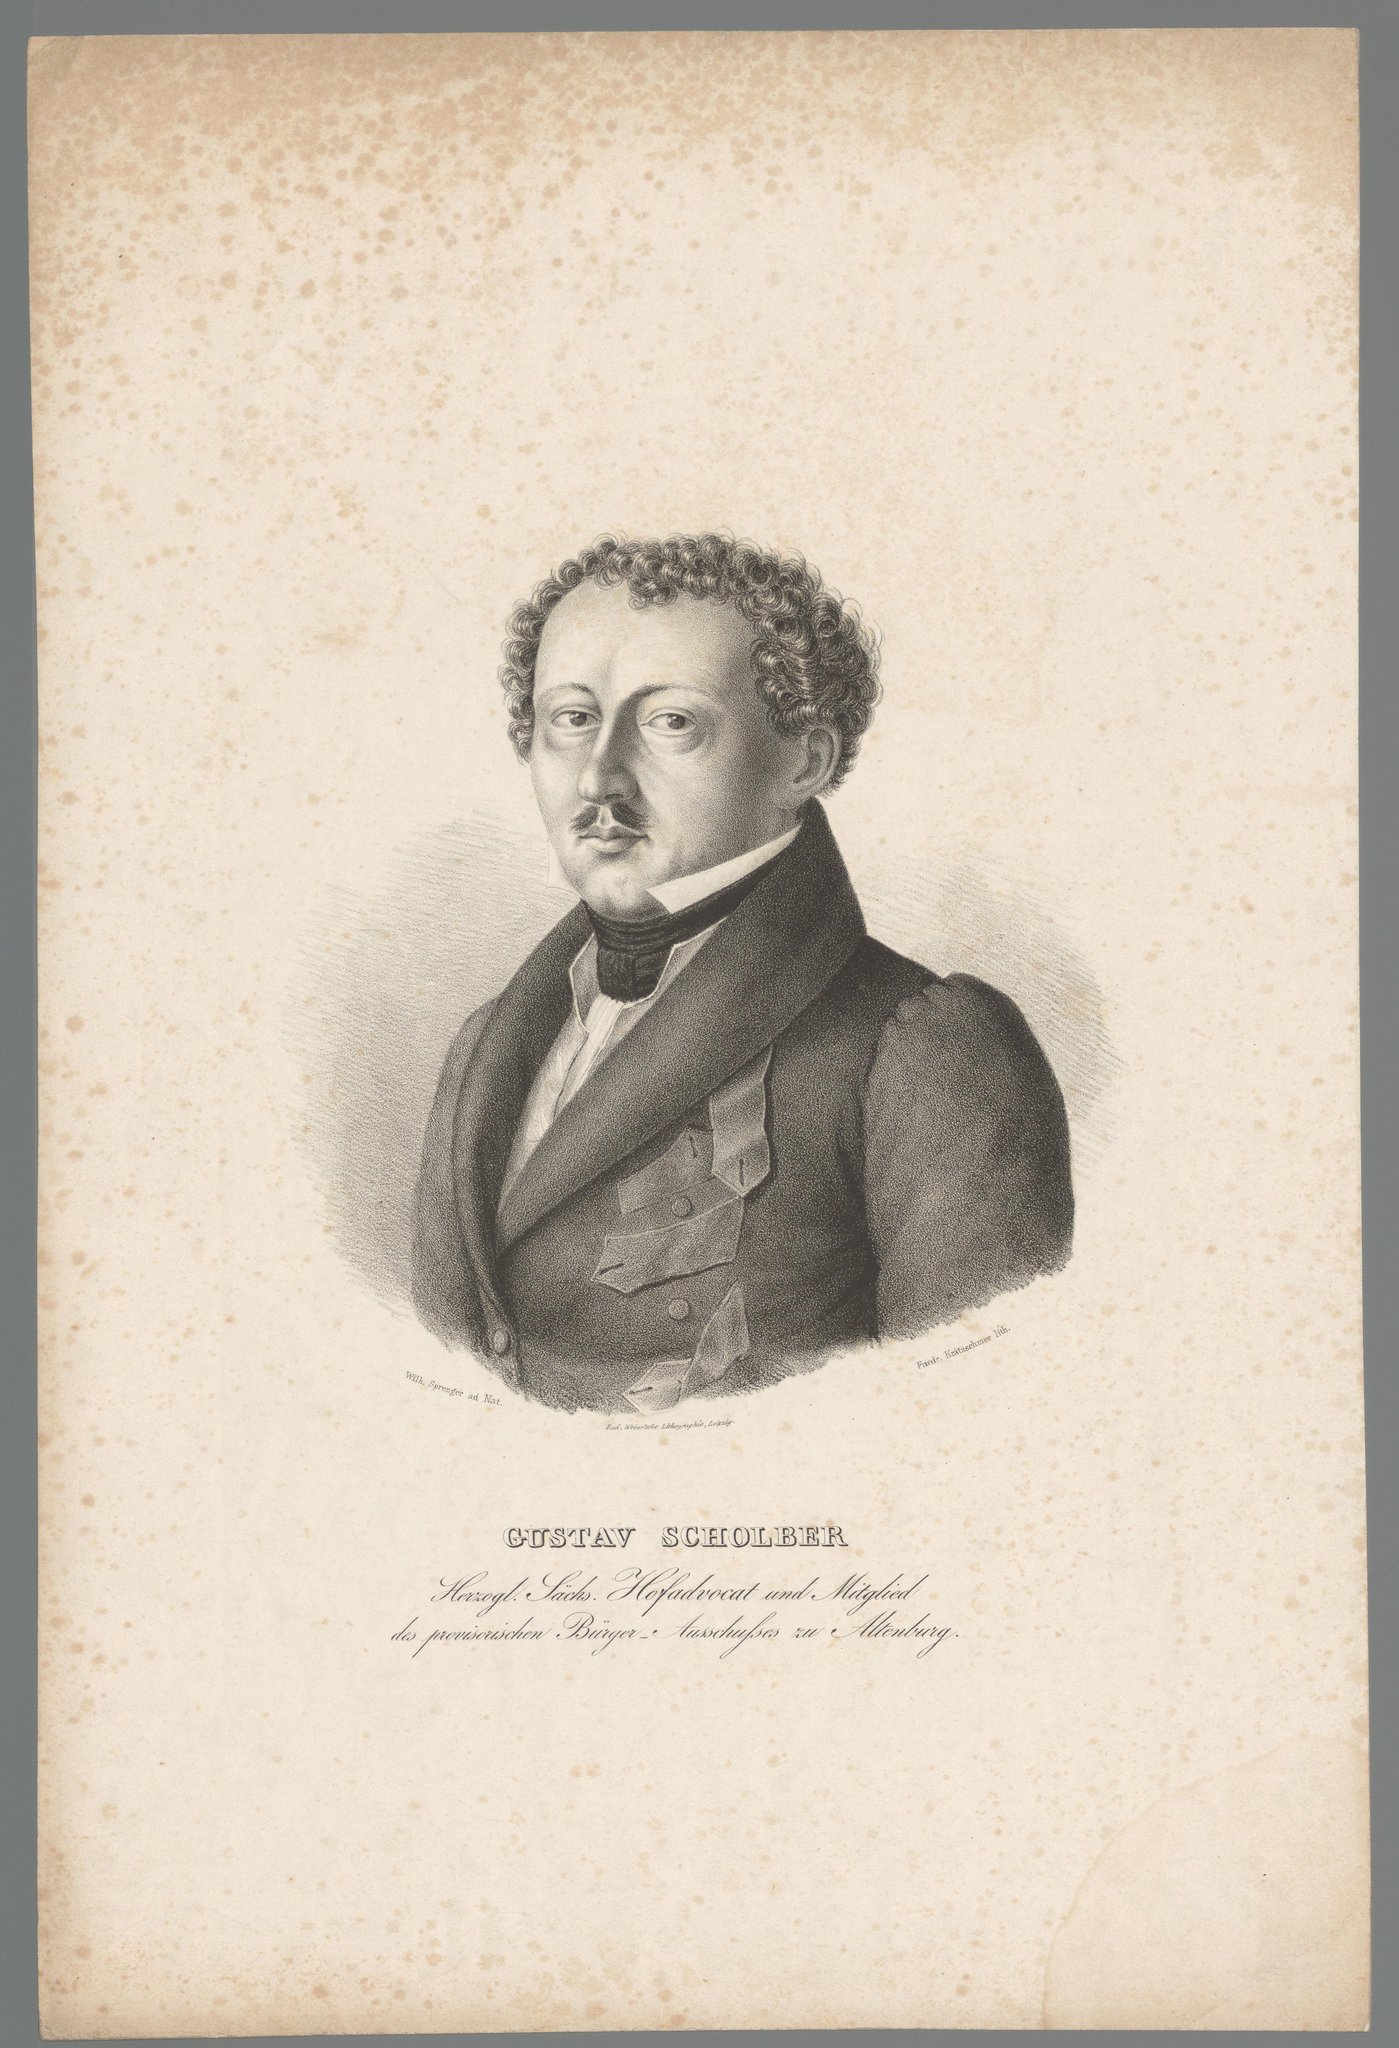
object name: print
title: Portret van Gustav Scholber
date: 1816-1886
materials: paper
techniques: lithograph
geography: leipzig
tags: historical persons not known by name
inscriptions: collector's mark: Lugt 2228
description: Portret van een verder onbekende man met de naam Gustav Scholber, advocaat.